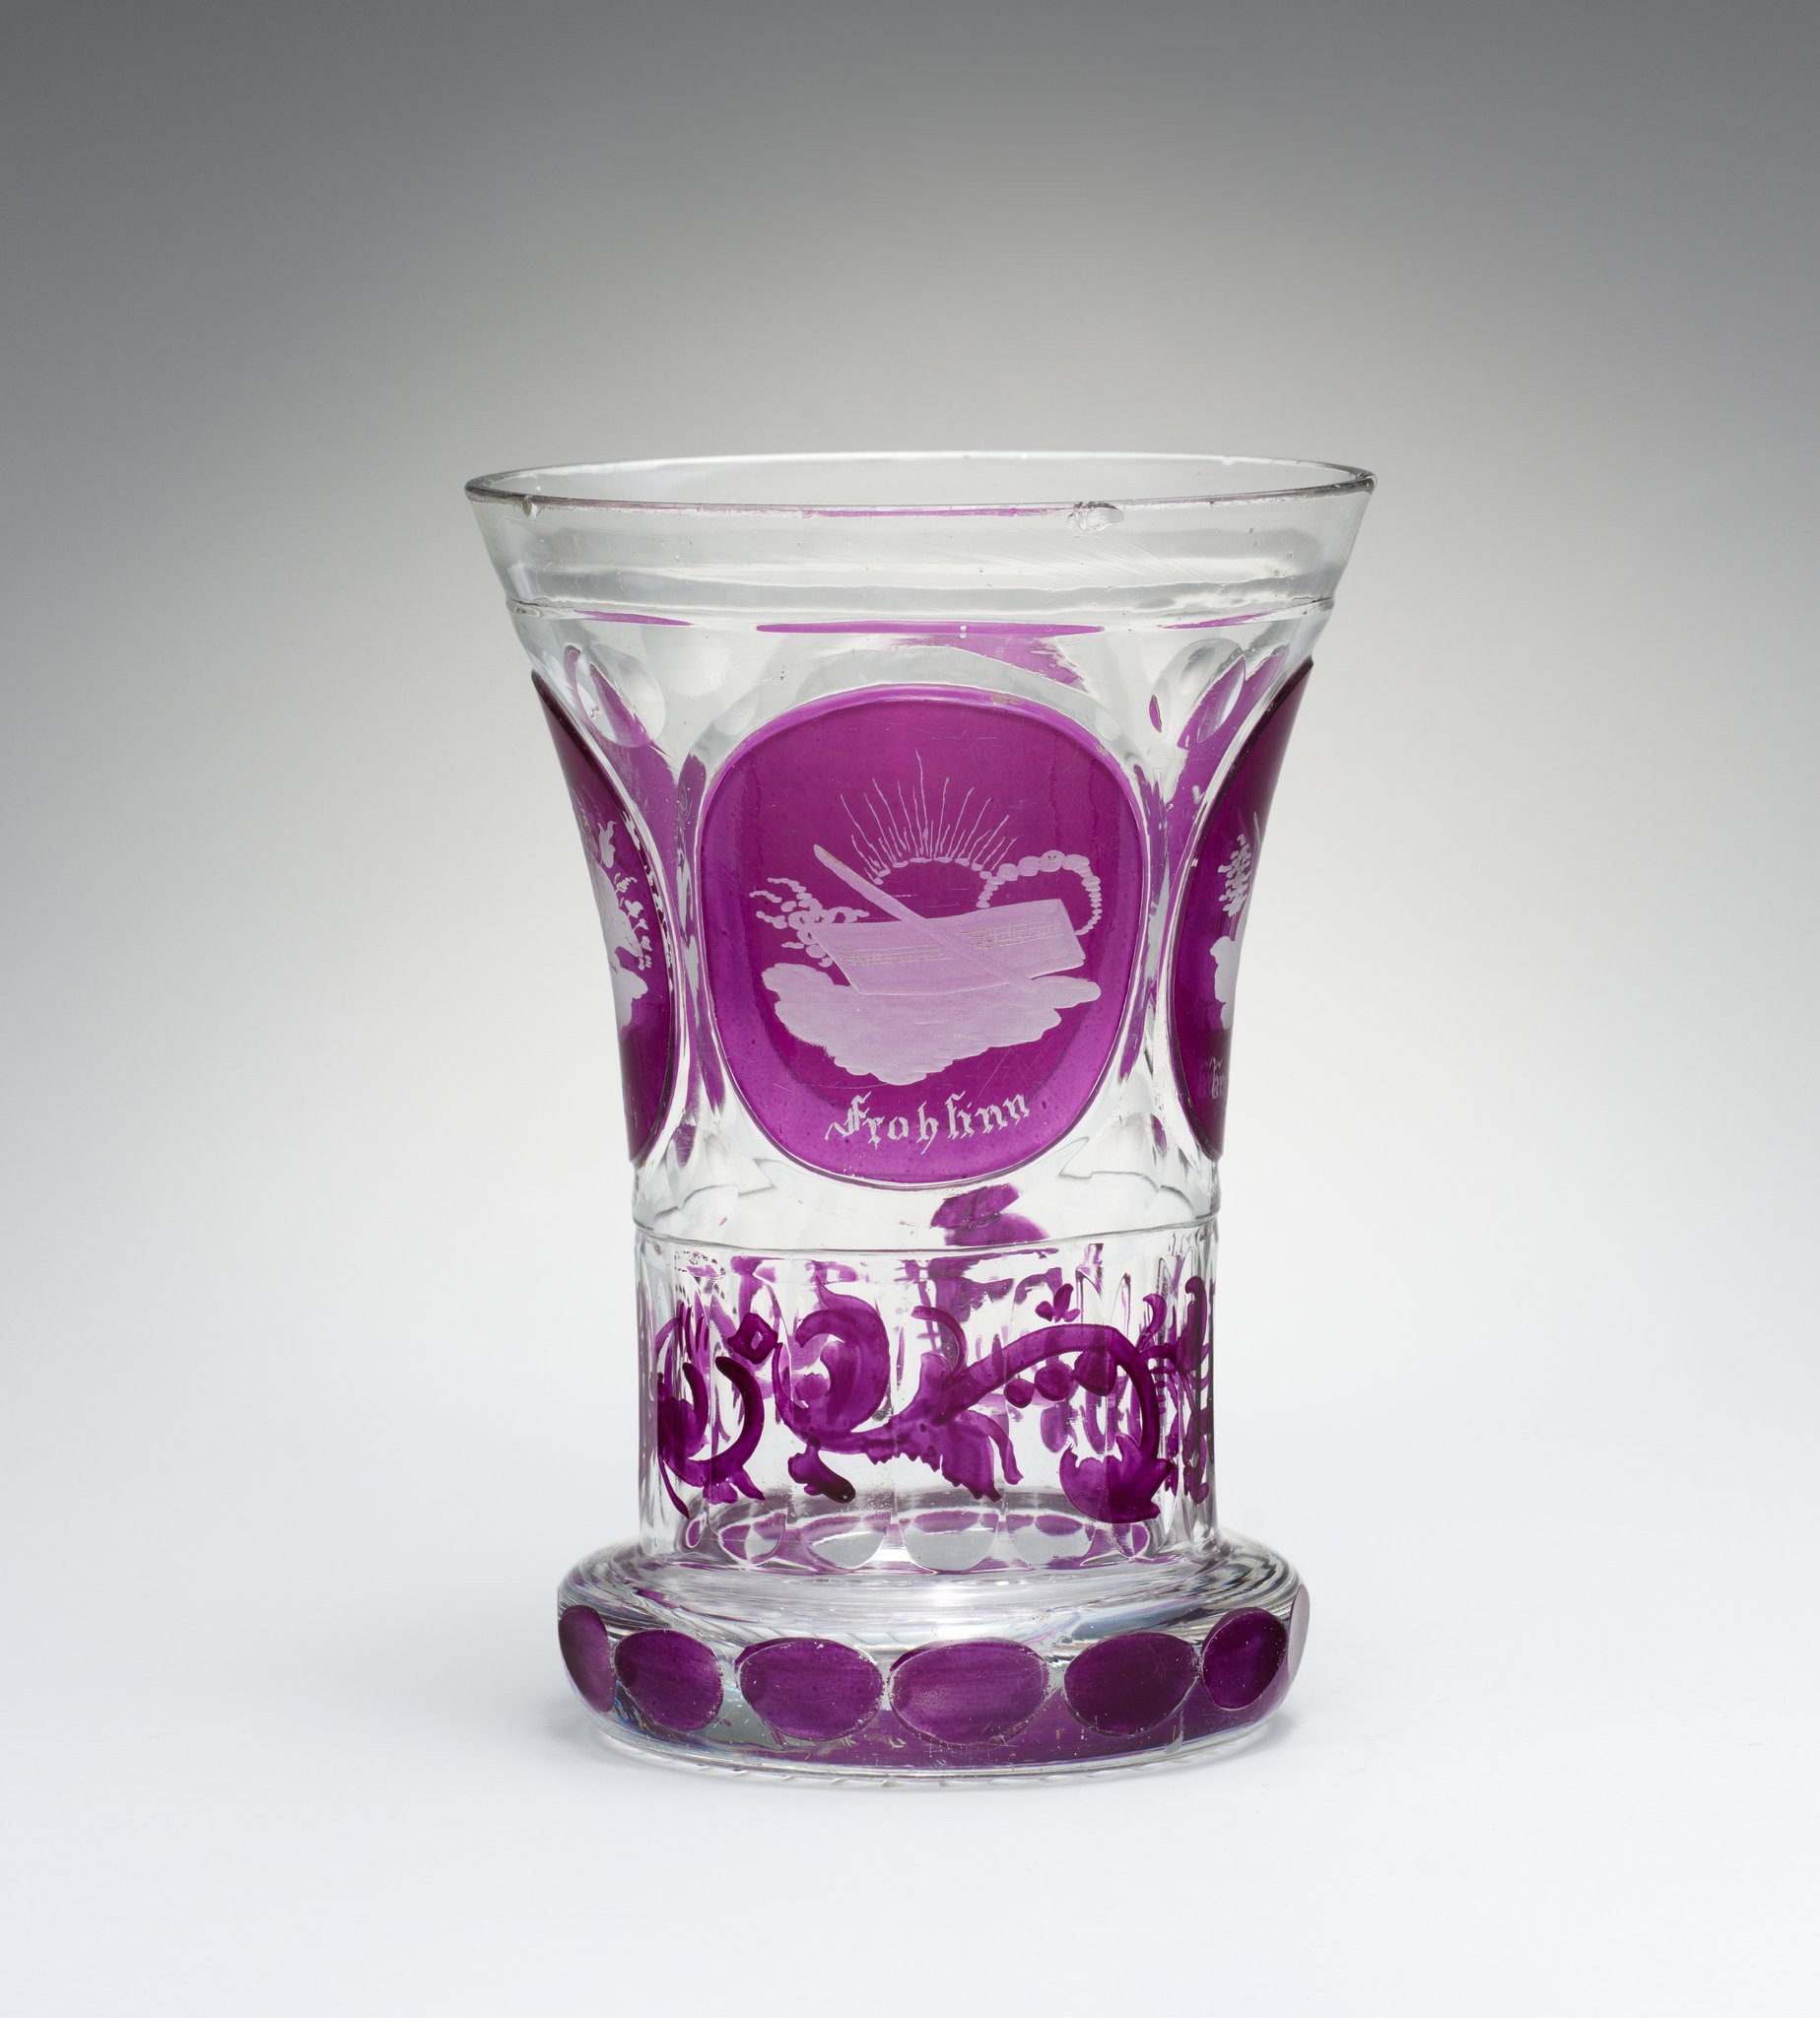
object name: beaker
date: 1830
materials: glass